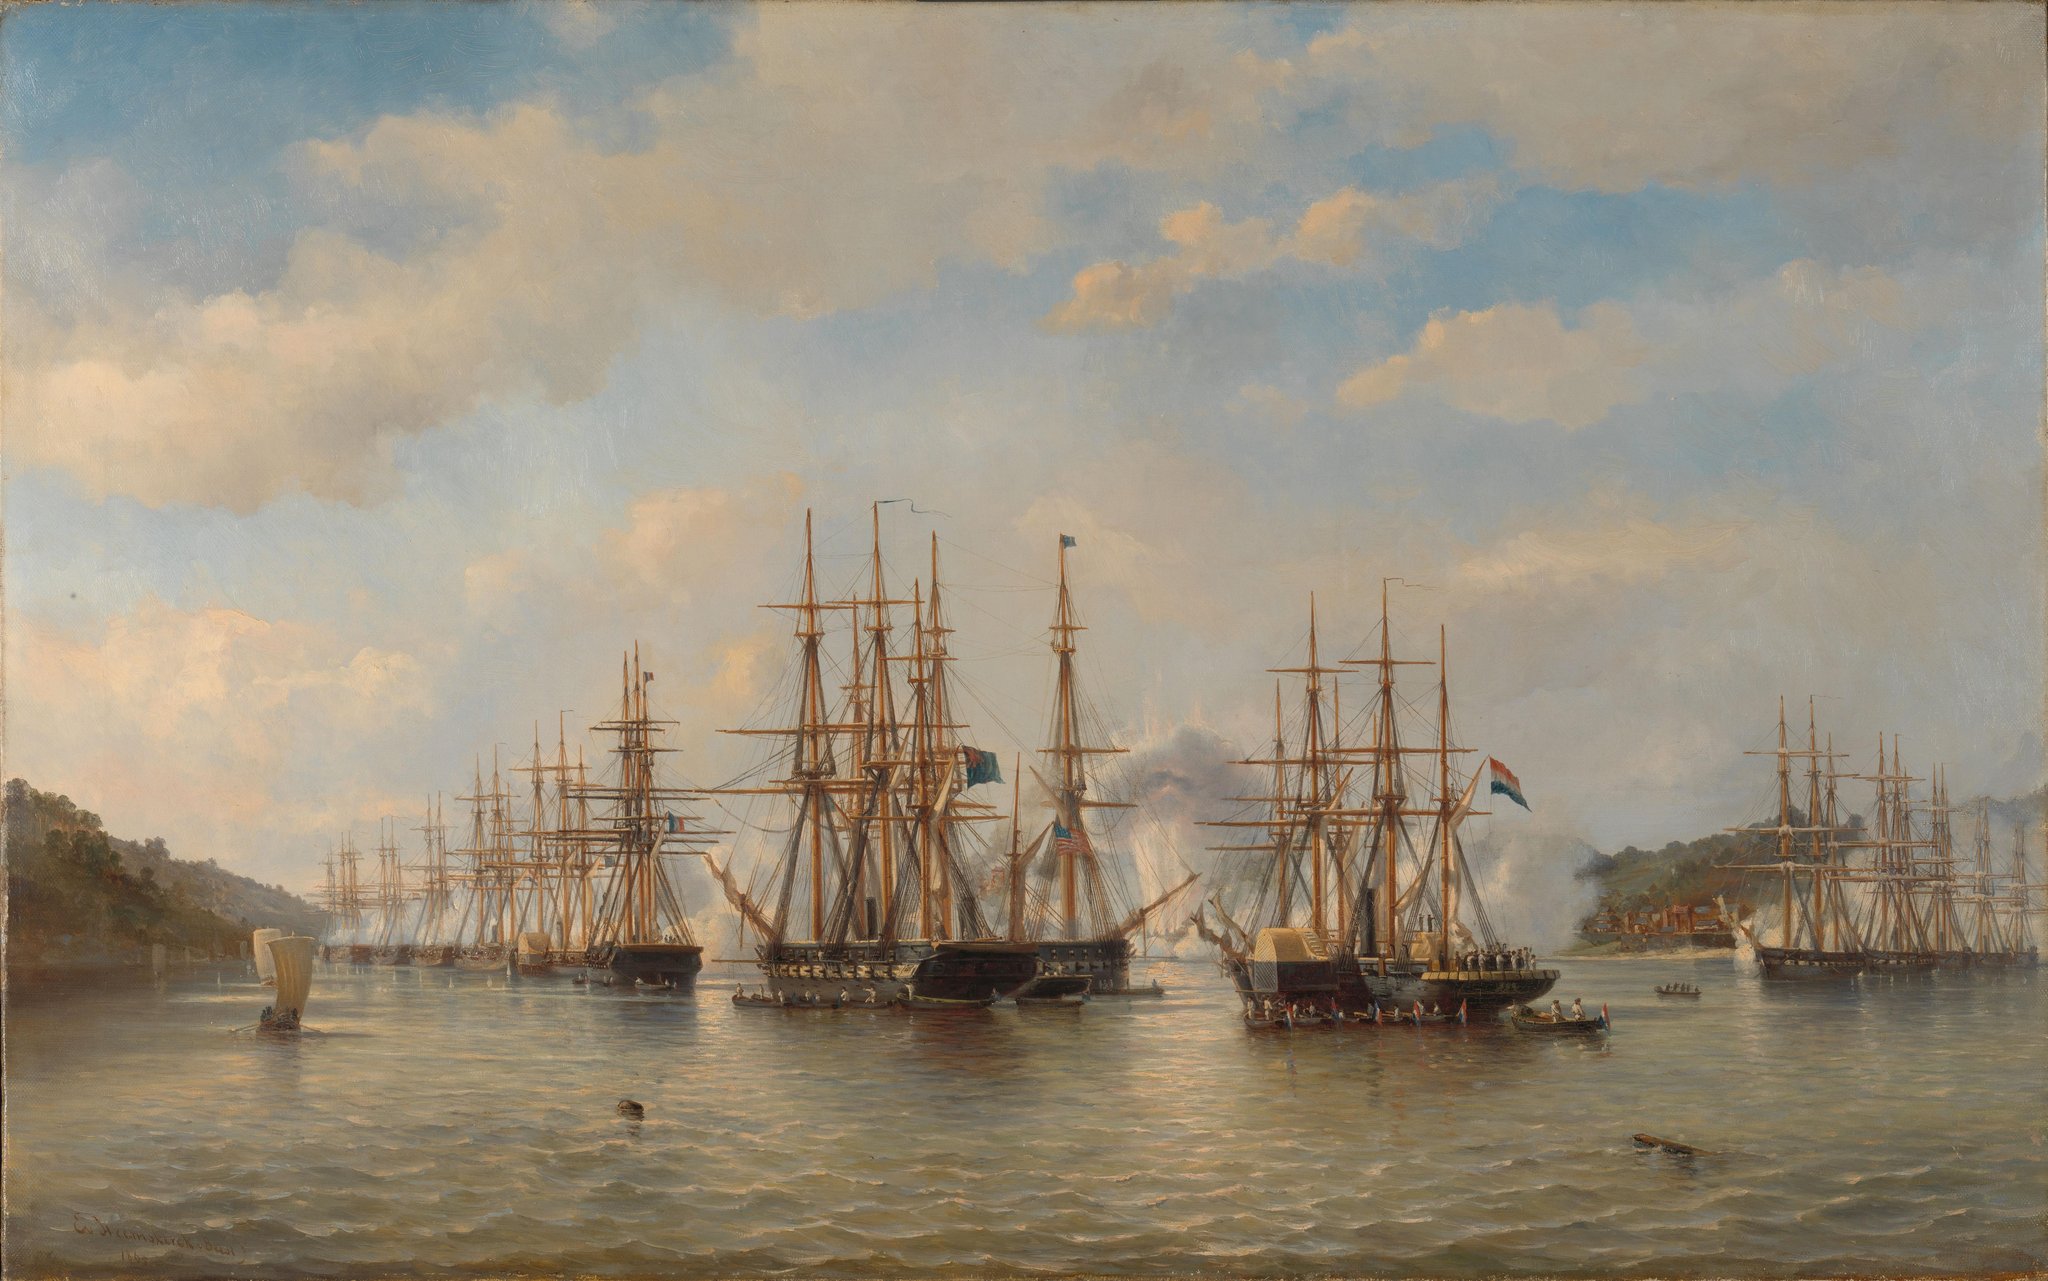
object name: painting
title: Dutch, English, French and American Squadrons in Japanese Waters during the Expedition led by the French Commander Constant Jaurès, September 1864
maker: jonkheer jacob eduard van heemskerck van beest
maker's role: painter, print maker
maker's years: 1828-1894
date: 1864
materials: canvas, oil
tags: sailing-ship, sailing-boat, parental blessings and admonitions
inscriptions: signature and date: ‘E. van Heemskerck v. Beest f. 1864’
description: De Nederlandse, Engelse, Franse en Amerikaanse eskaders in de Japanse wateren tijdens de expeditie onder leiding van de Franse commandant Constant Jaurès, september 1864. Vloot van zeilschepen en stoomschepen in het water voor de kust van Japan. Tussen de schepen meerdere roeiboten. Pendant van SK-A-2725.